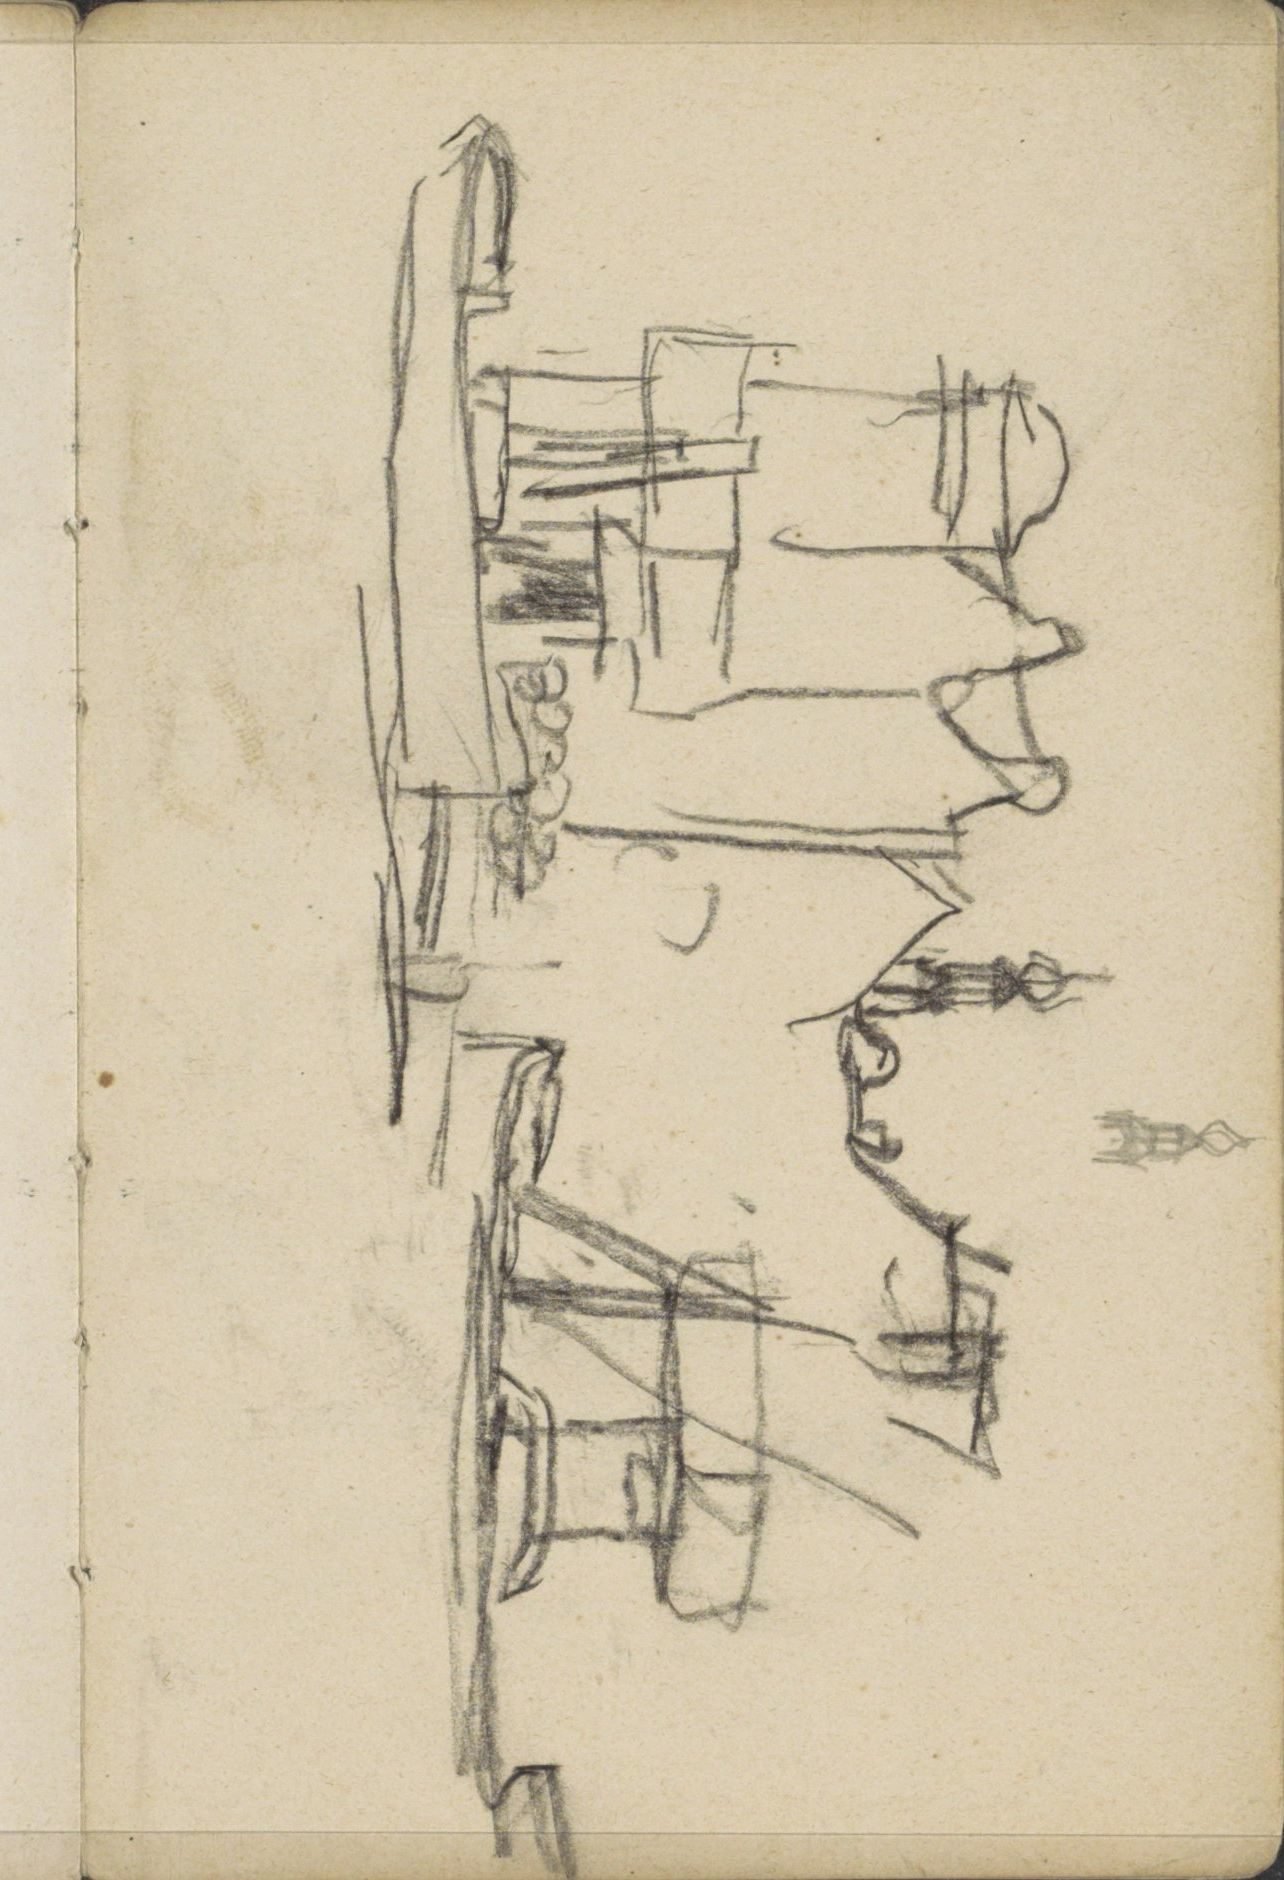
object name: sketchbook leaf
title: Gezicht op boten aan het Damrak te Amsterdam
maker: george hendrik breitner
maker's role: draughtsman, painter, print maker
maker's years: 1857-1923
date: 1903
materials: chalk, paper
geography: amsterdam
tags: urban housing, ships (in general), canals, waters (in city), parts of church exterior and annexes: tower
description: Gezicht op boten aan het Damrak te Amsterdam. In de verte de toren van de Oude Kerk. Pagina 88 uit een schetsboek met 46 bladen vervaardigd te Amsterdam en Haarlem.